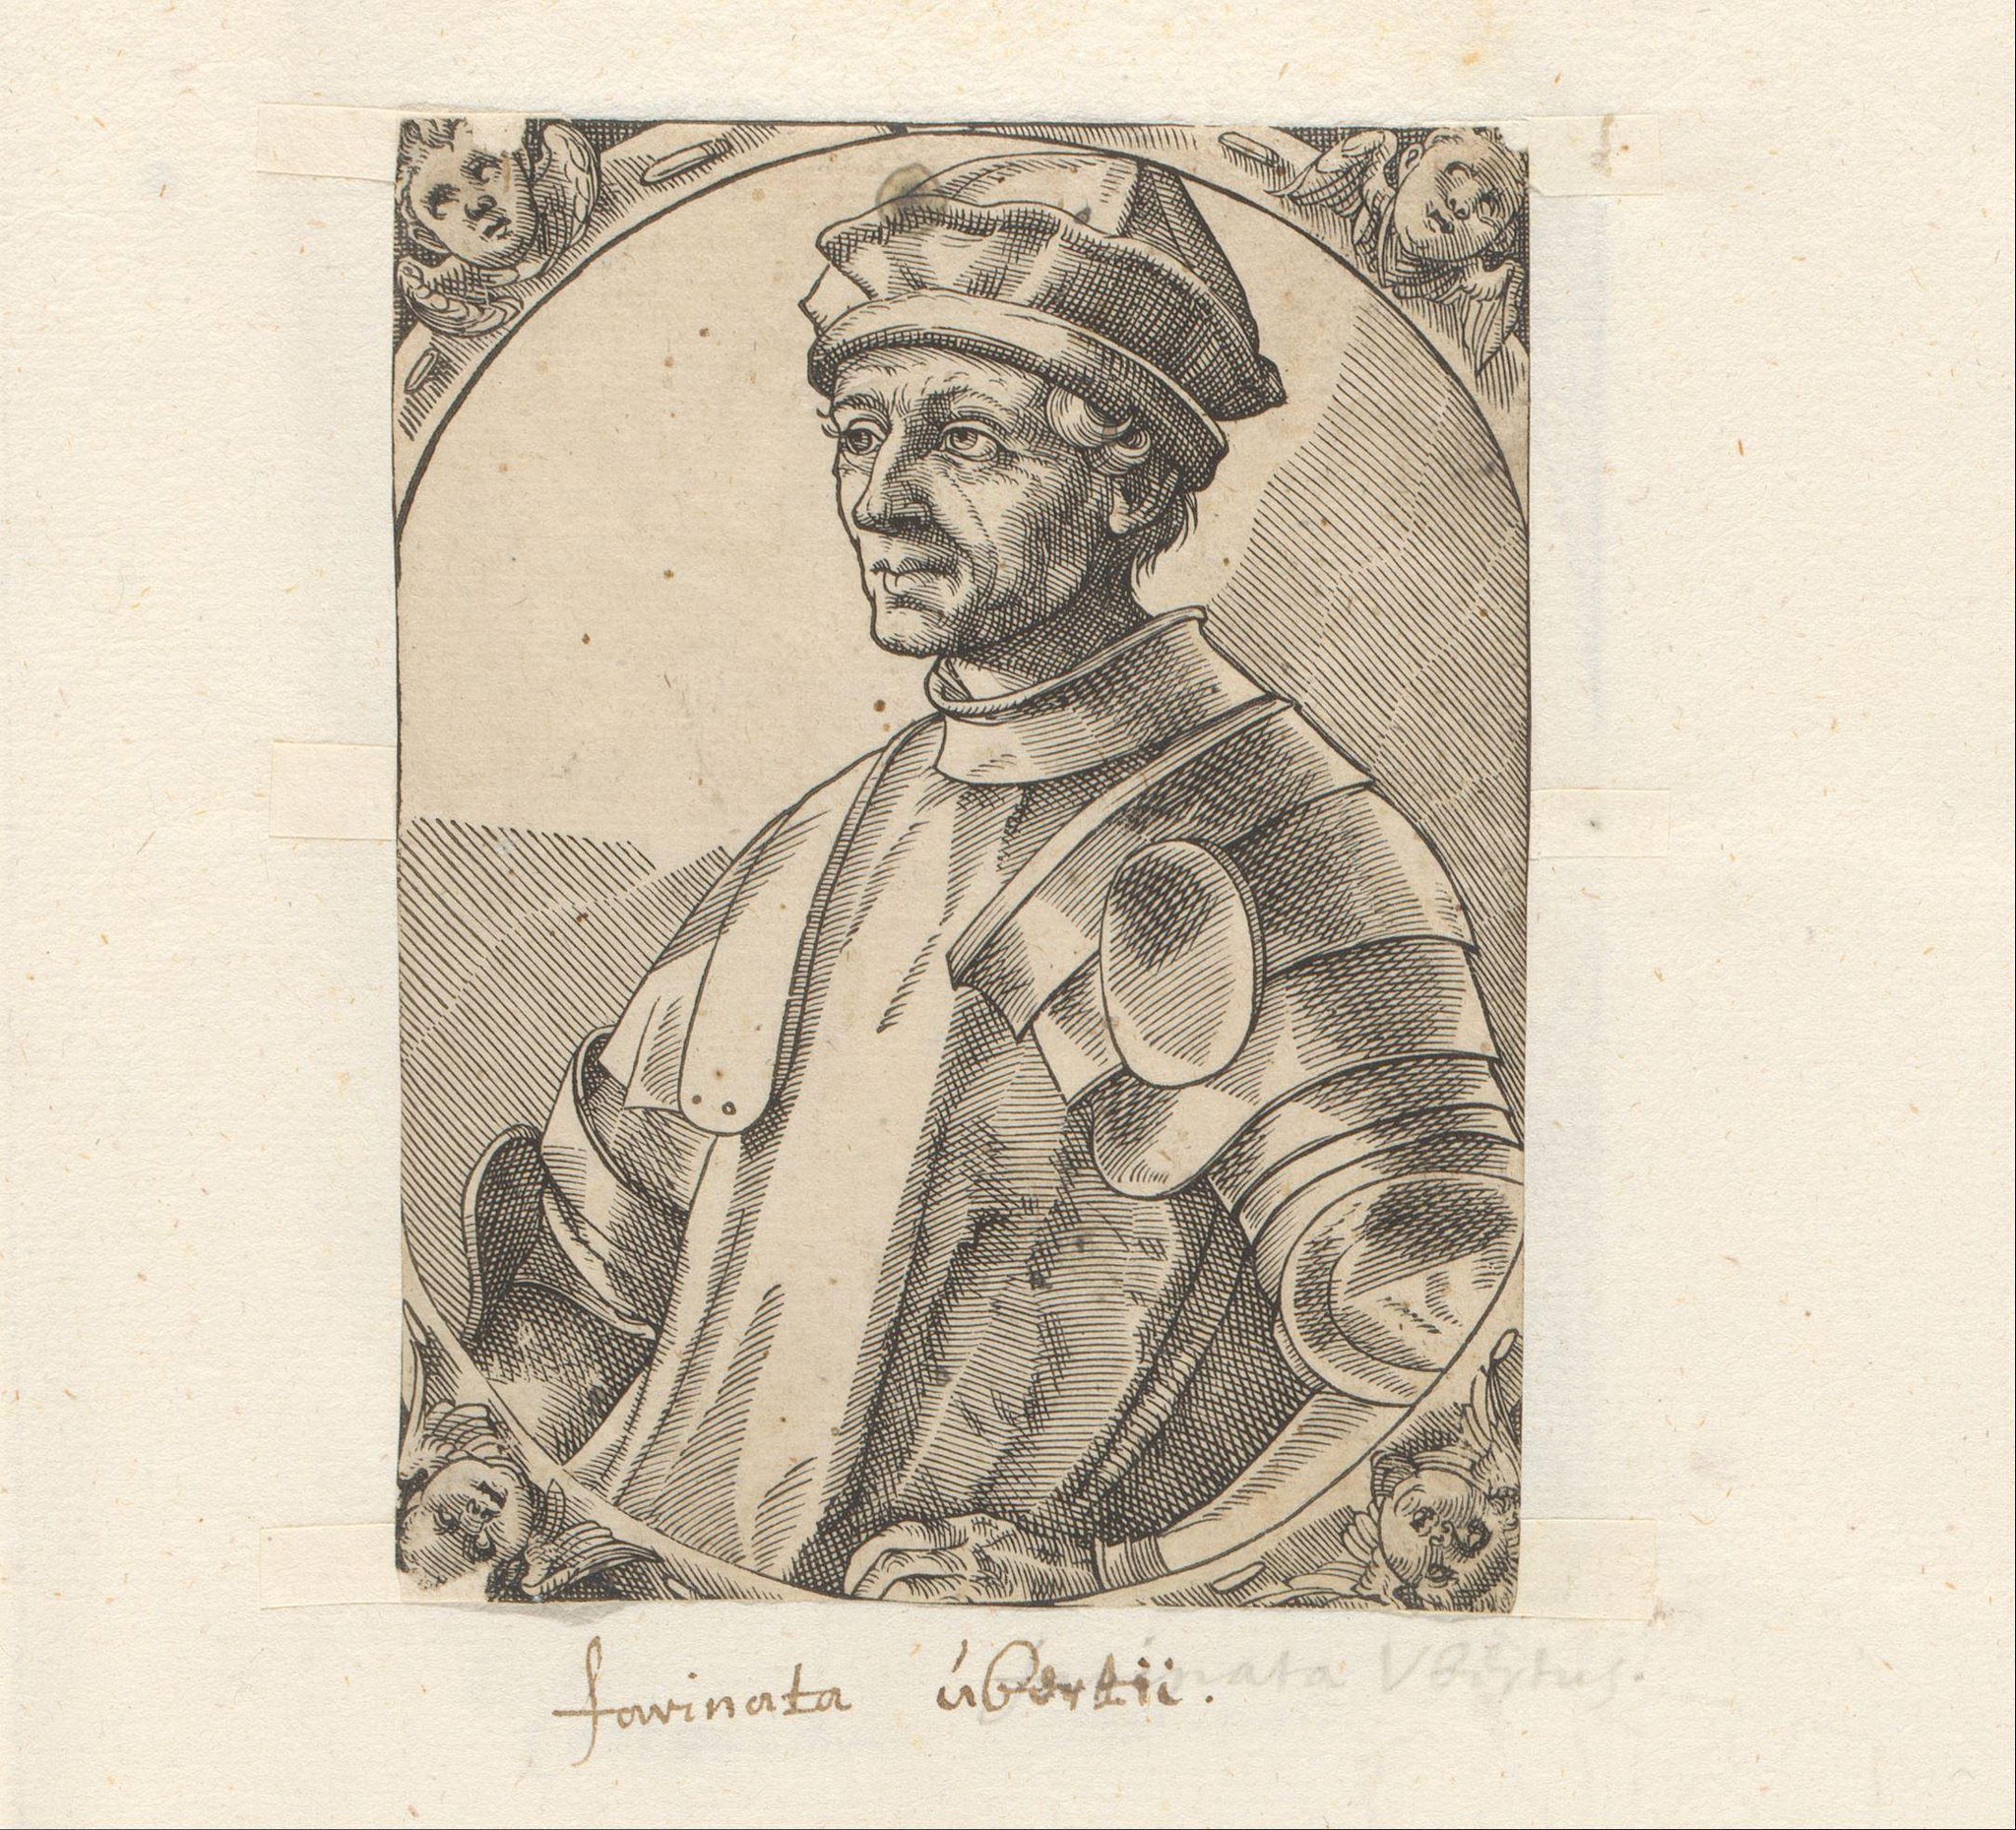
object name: print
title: Portret van Farinata degli Uberti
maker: Anonymous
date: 1549-1575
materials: paper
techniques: woodcut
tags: historical persons, politician, e.g. party leader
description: Prent gebruikt in: Giovio, Paolo. Elogia Virorum bellica virtute illustrium (...). Bazel: Peter Perna, 1575.